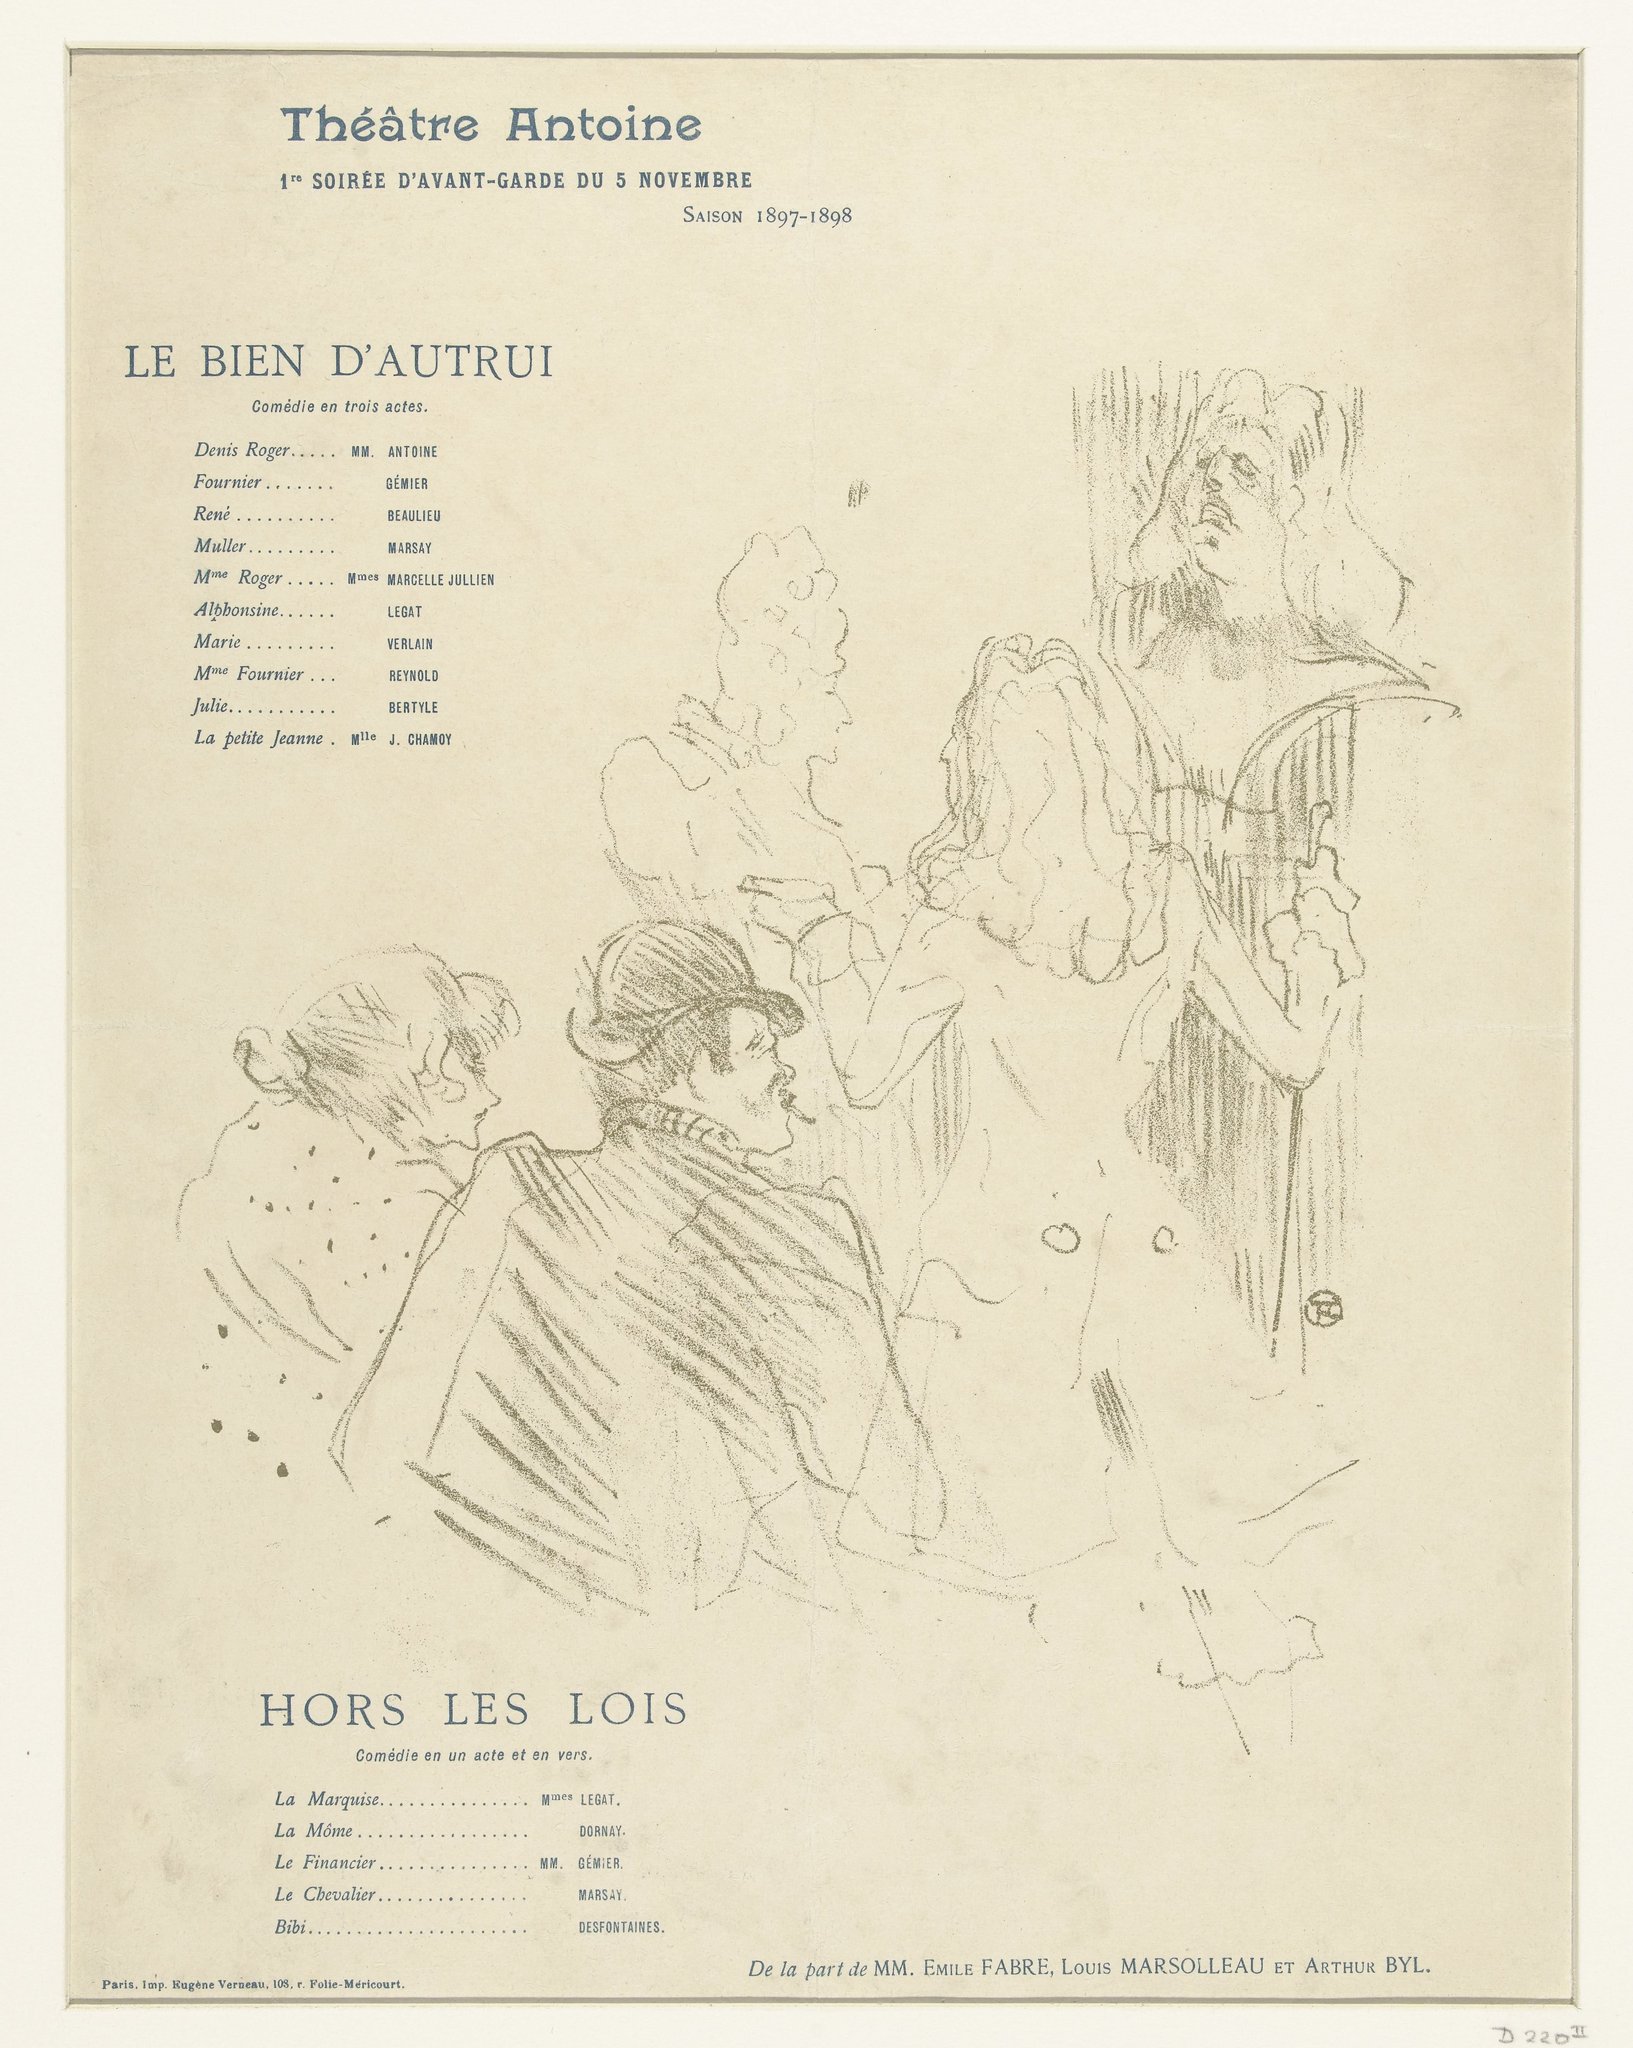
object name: print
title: Hommage à Molière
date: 1897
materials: paper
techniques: printing, lithograph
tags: paris, jean baptiste poquelin molière, group of actors, troupe; actors on the stage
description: Programma voor twee toneelstukken met de titels Le bien d'autrui en Hors les lois. Vier acteurs staan bij de buste van Molière. Het Théâtre Antoine bracht met dit komische toneel een eerbetoon aan de Franse toneelschrijver. Onder beide titels staat een rolverdeling met namen van acteurs en rollen.